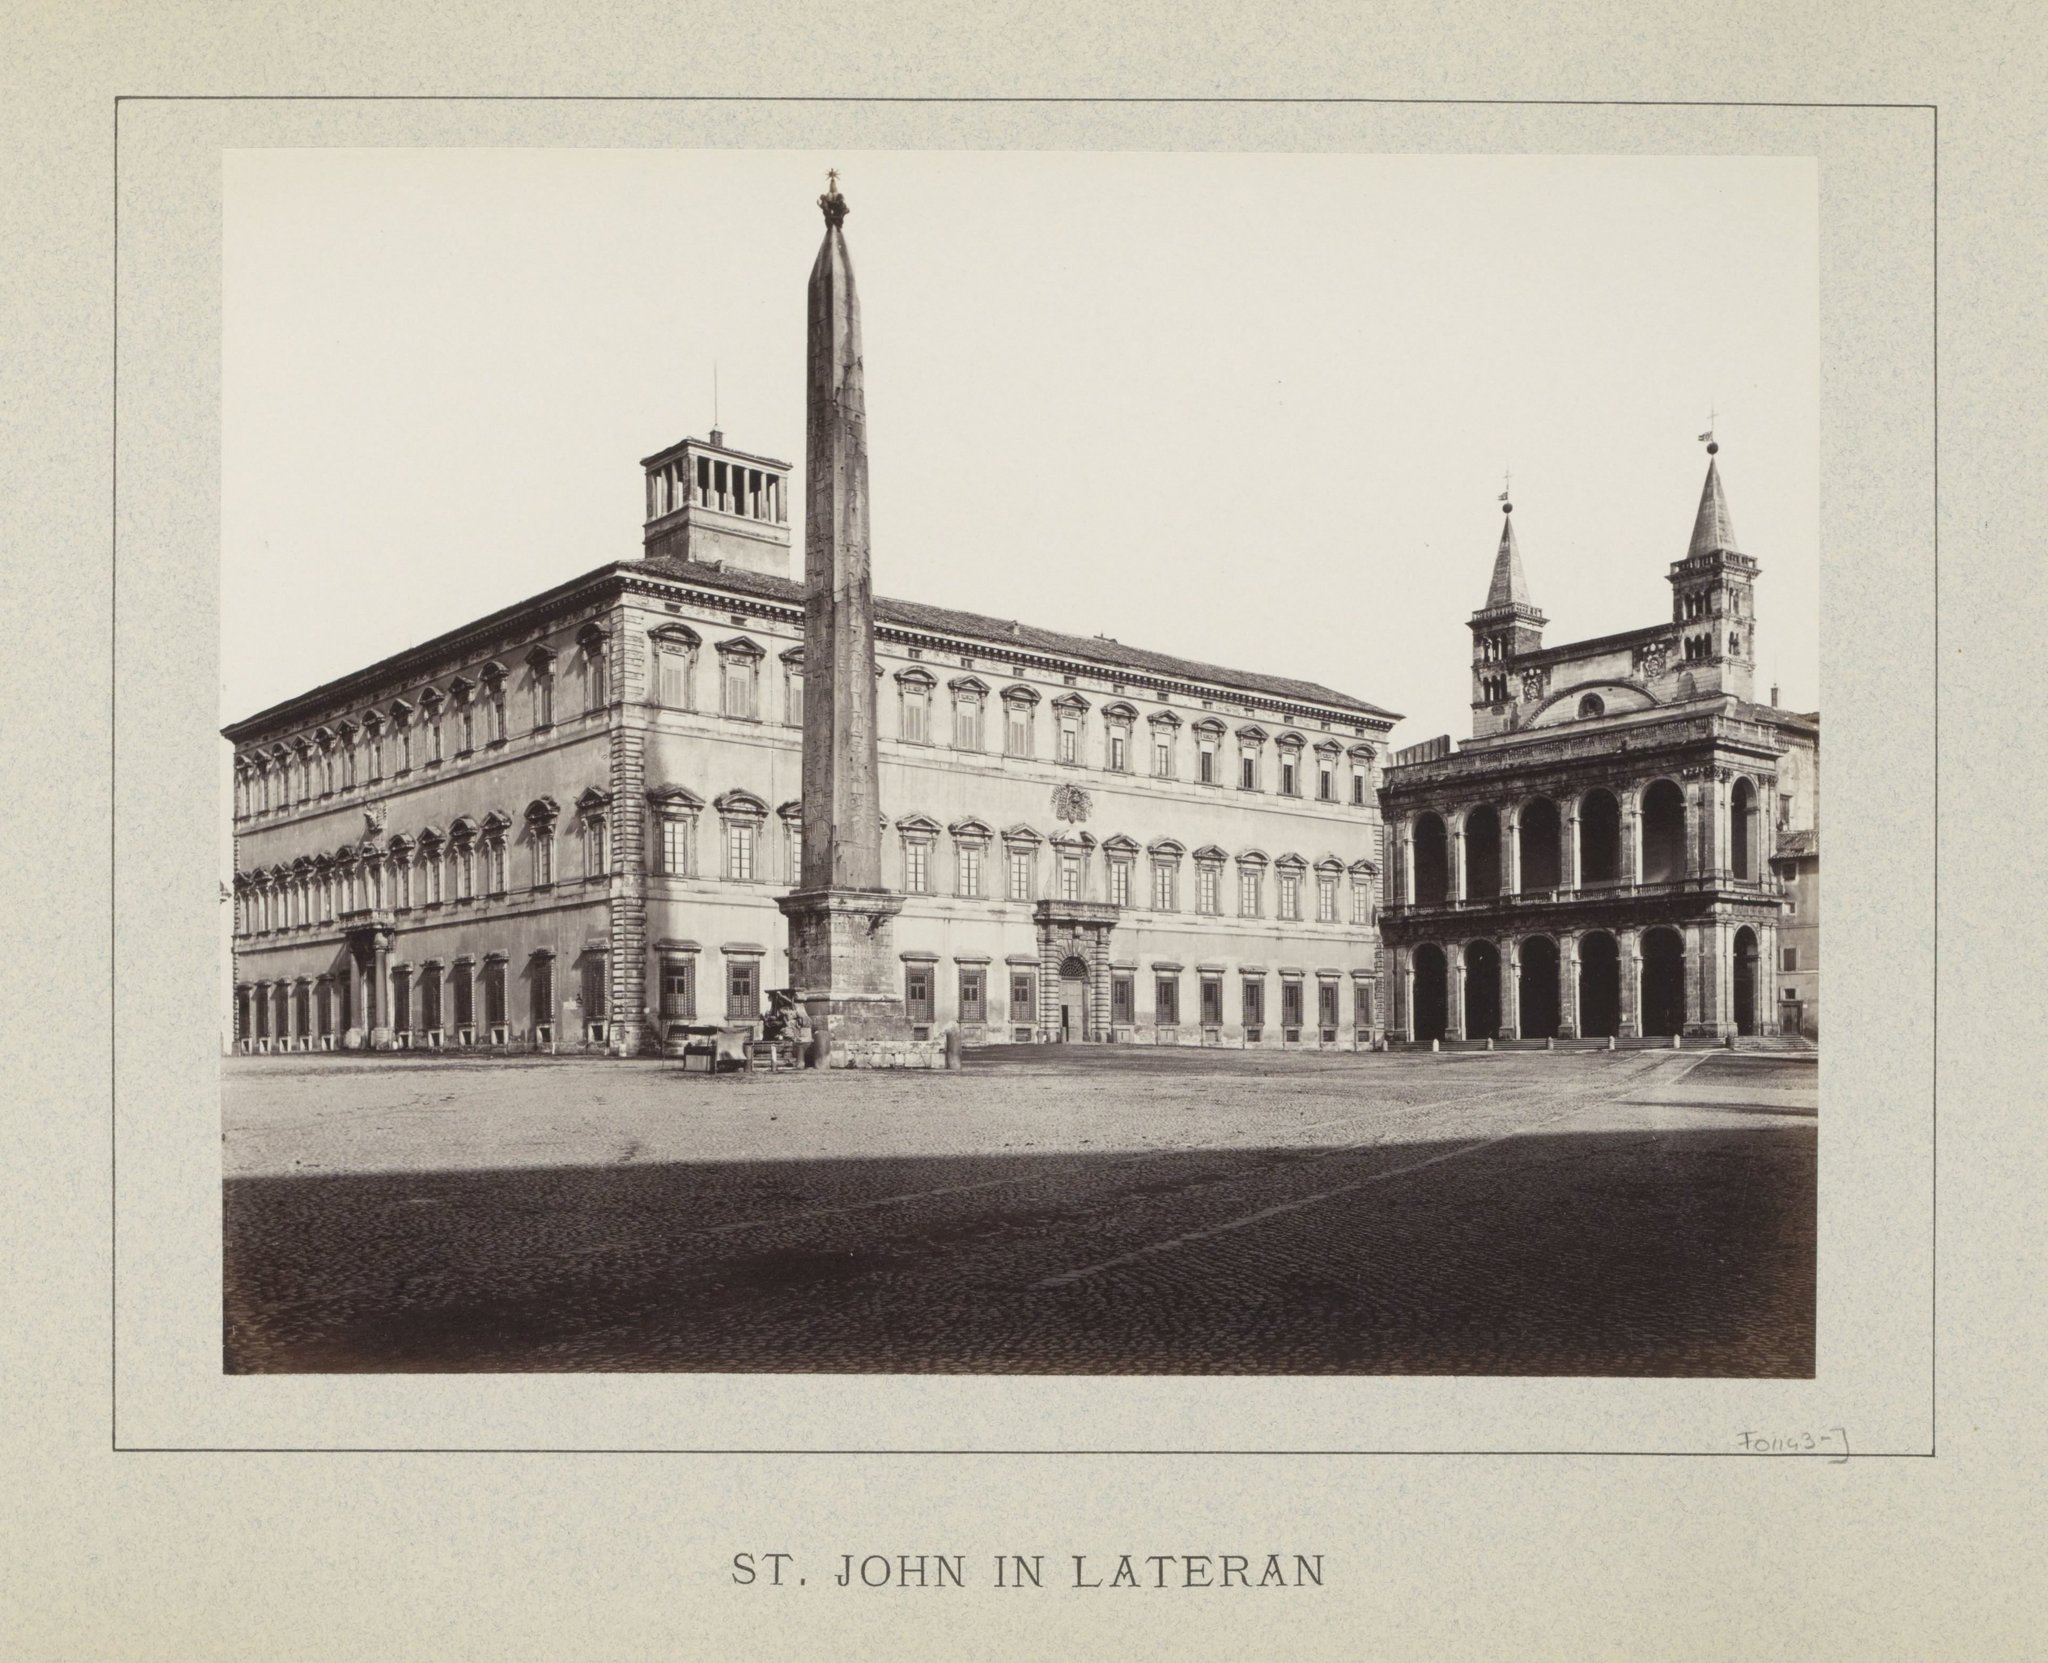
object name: photograph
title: Lateraanse Obelisk voor het Lateraans Paleis (links) en de Loggia delle Benedizioni in Rome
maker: Anonymous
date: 1860-1900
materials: photographic support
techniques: albumen print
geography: rome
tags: obelisk, needle, square, place, circus, etc. (+ city(-scape) with figures, staffage)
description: Onderdeel van Fotoalbum met opnames van bezienswaardigheden en kunstwerken in Rome.